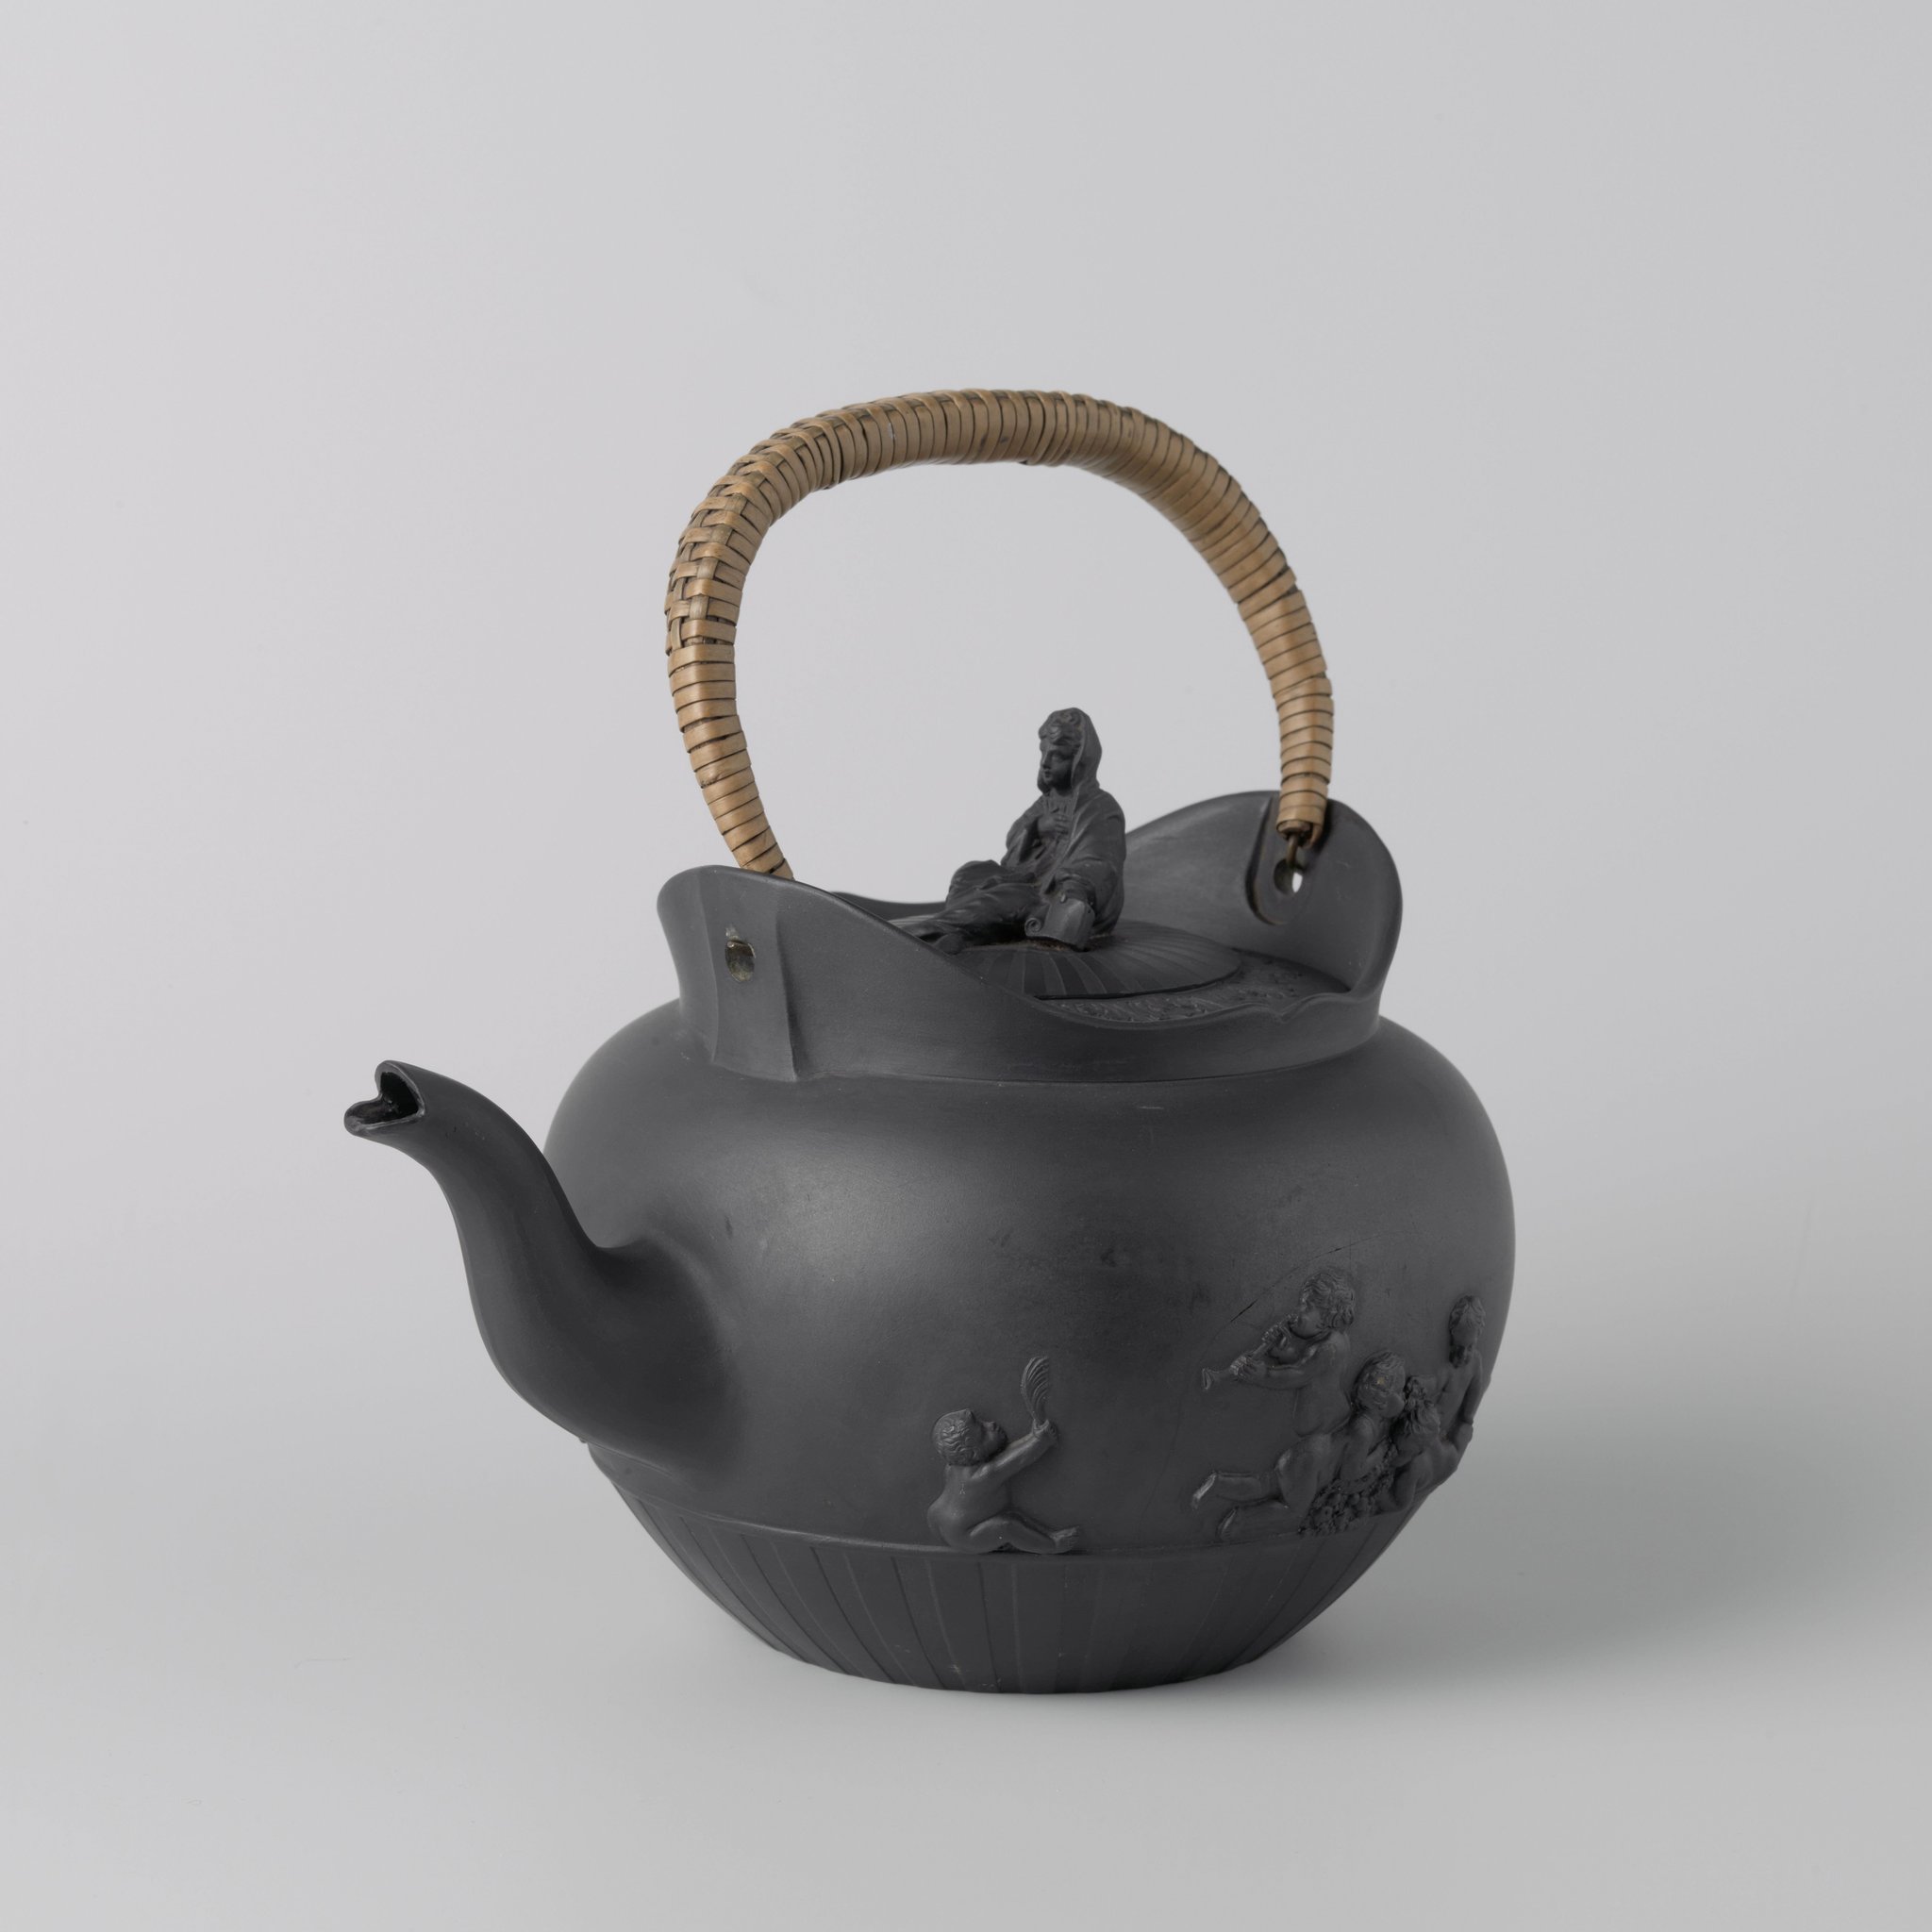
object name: chocoladeketel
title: Chocoladeketel met deksel van aardewerk, Wedgwood Black Basalt. Met deksel.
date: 1785-1800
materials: earthenware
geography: england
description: Bolvormige chocoladeketel met deksel van aardewerk, Black Basalt. De ketel heeft een opstaande, accoladevormige rand met twee gaten waarin het losse hengsel van omwonden riet hangt. De tuit is S-vormig en het deksel heeft een knop in de vorm van een zittende vrouw met in haar linker hand een stuk papier. De buik van de ketel is in reliëf versierd met spelende naakte kinderen, boven een rand van uitgeslepen verticale biezen. De ketel is gemerkt.